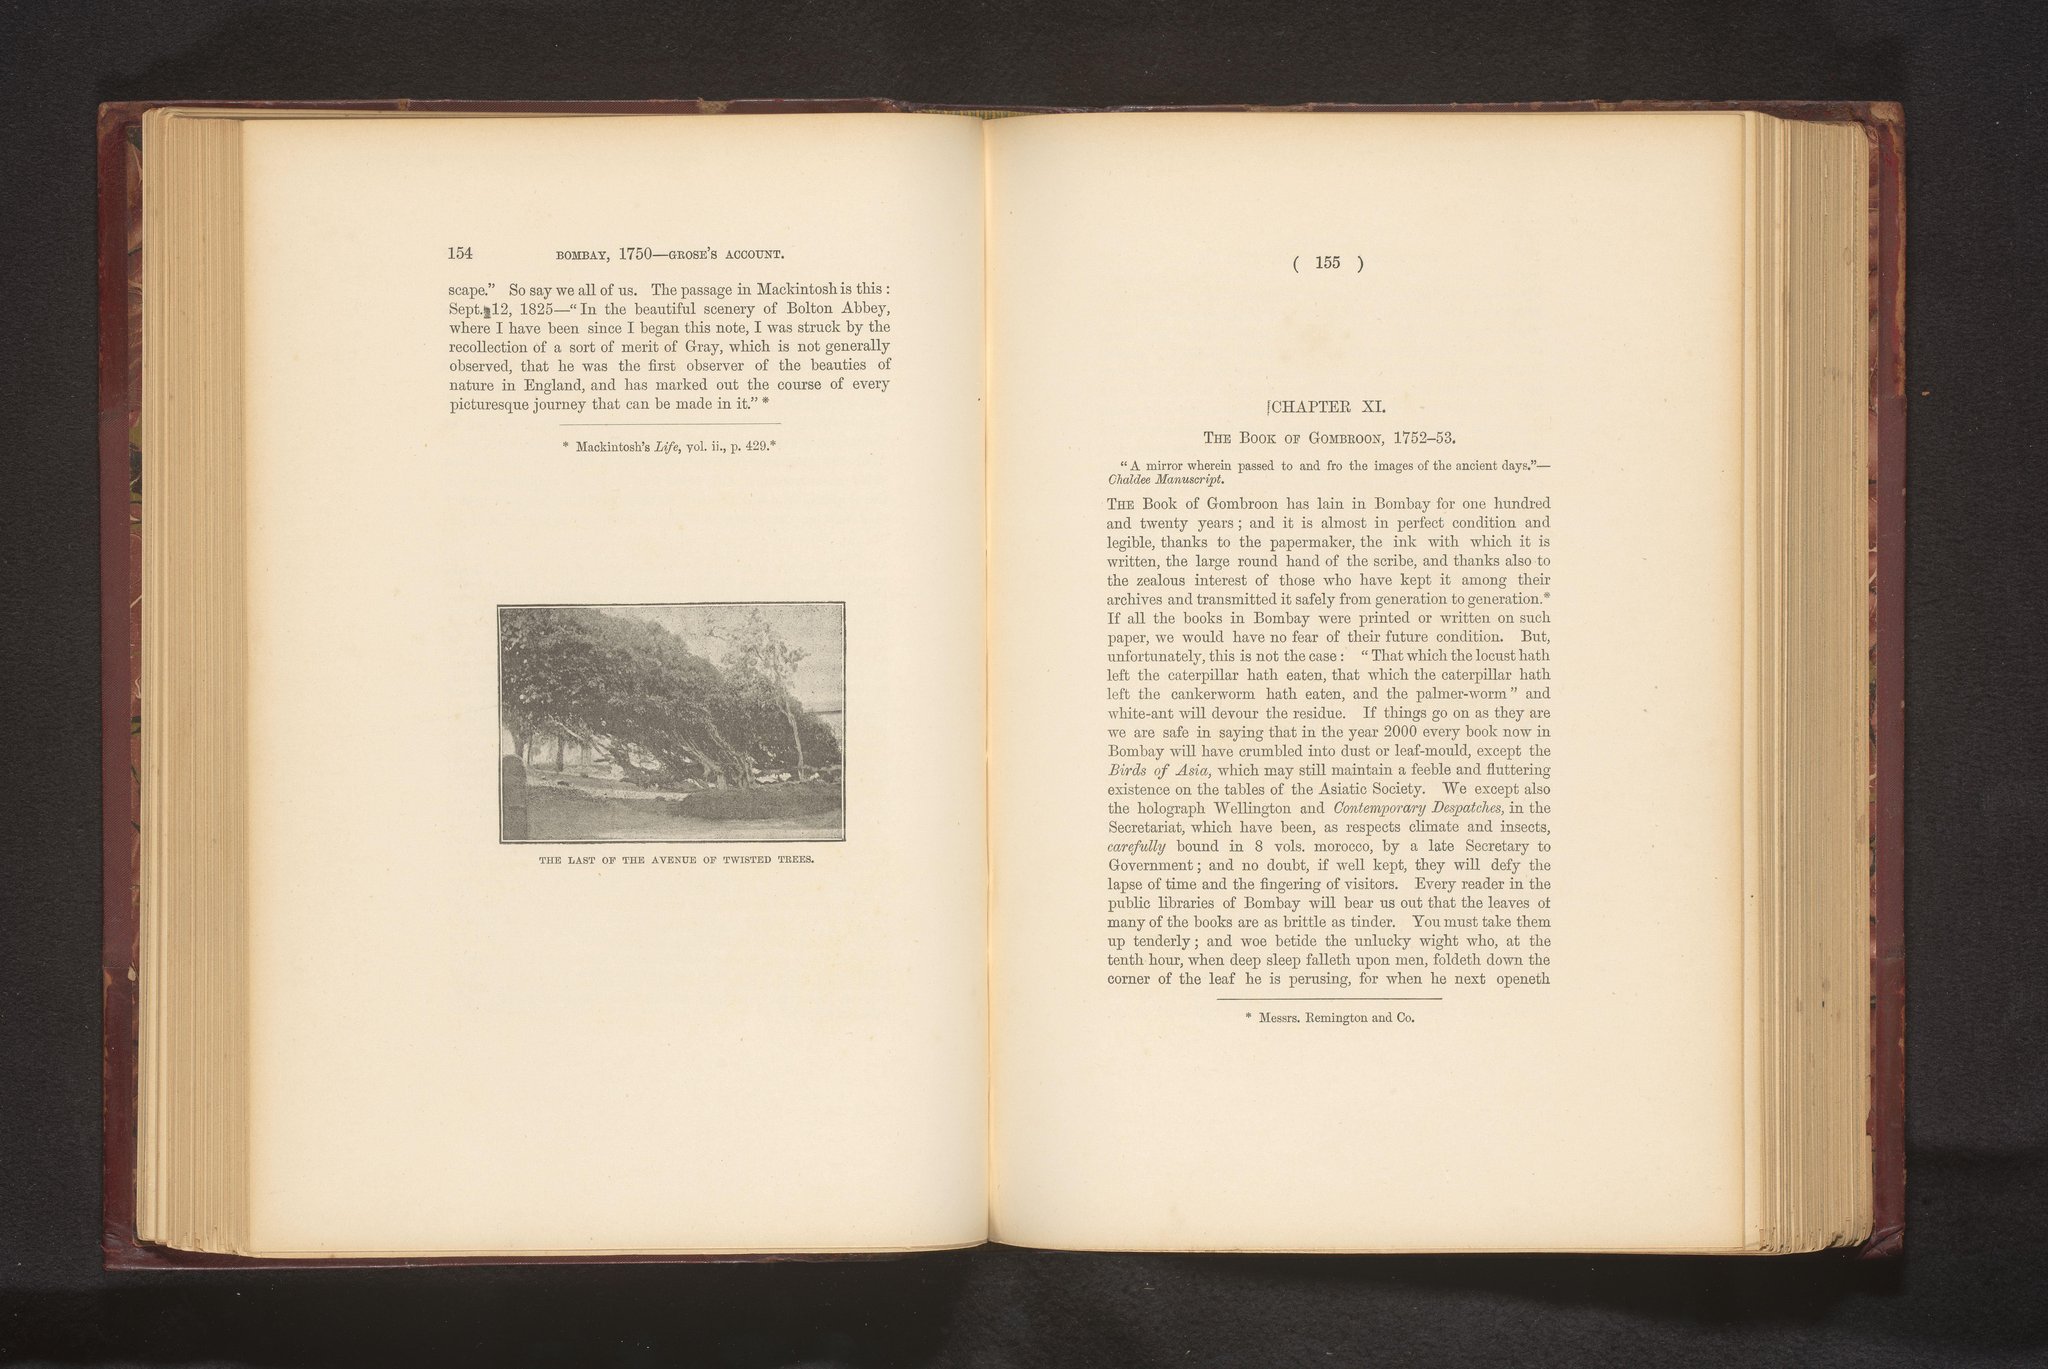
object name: page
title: Trees along a lane in Mumbai, Maharashtra, India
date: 1883-1893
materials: paper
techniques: autotype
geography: mumbai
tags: trees, lane, alley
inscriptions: caption: ‘THE LAST OF THE AVENUE OF TWISTED TREES.’